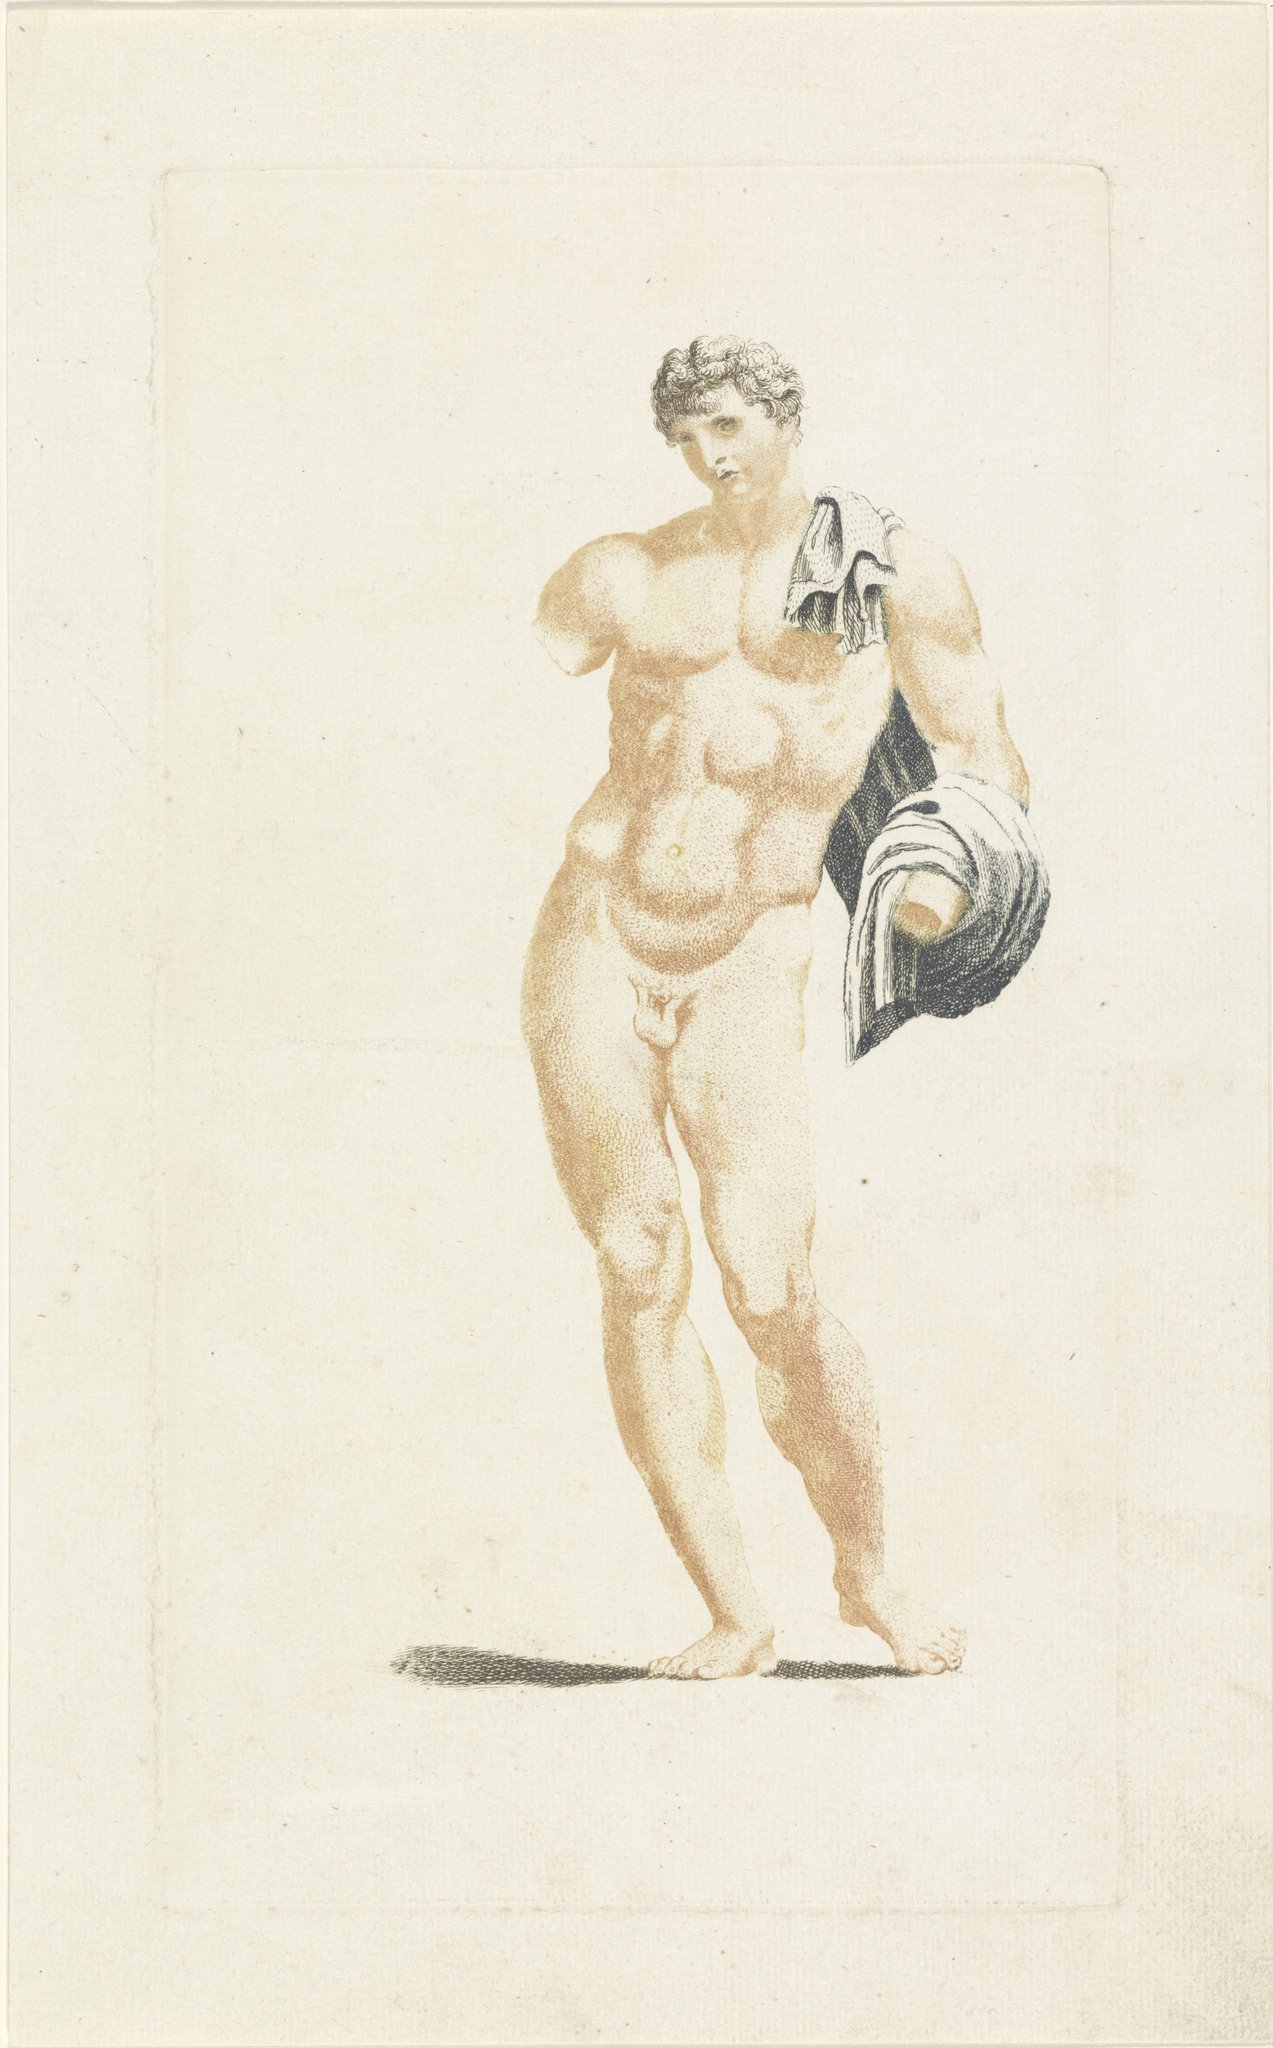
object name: print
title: Klassieke sculptuur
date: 1688-1698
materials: paper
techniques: engraving, etching, lithography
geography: netherlands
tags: piece of sculpture, reproduction of a piece of sculpture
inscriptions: collector's mark: Lugt 2228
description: Klassieke sculptuur, wellicht Apollo. De rechterarm ontbreekt en van de linkerarm ontbreekt de hand.